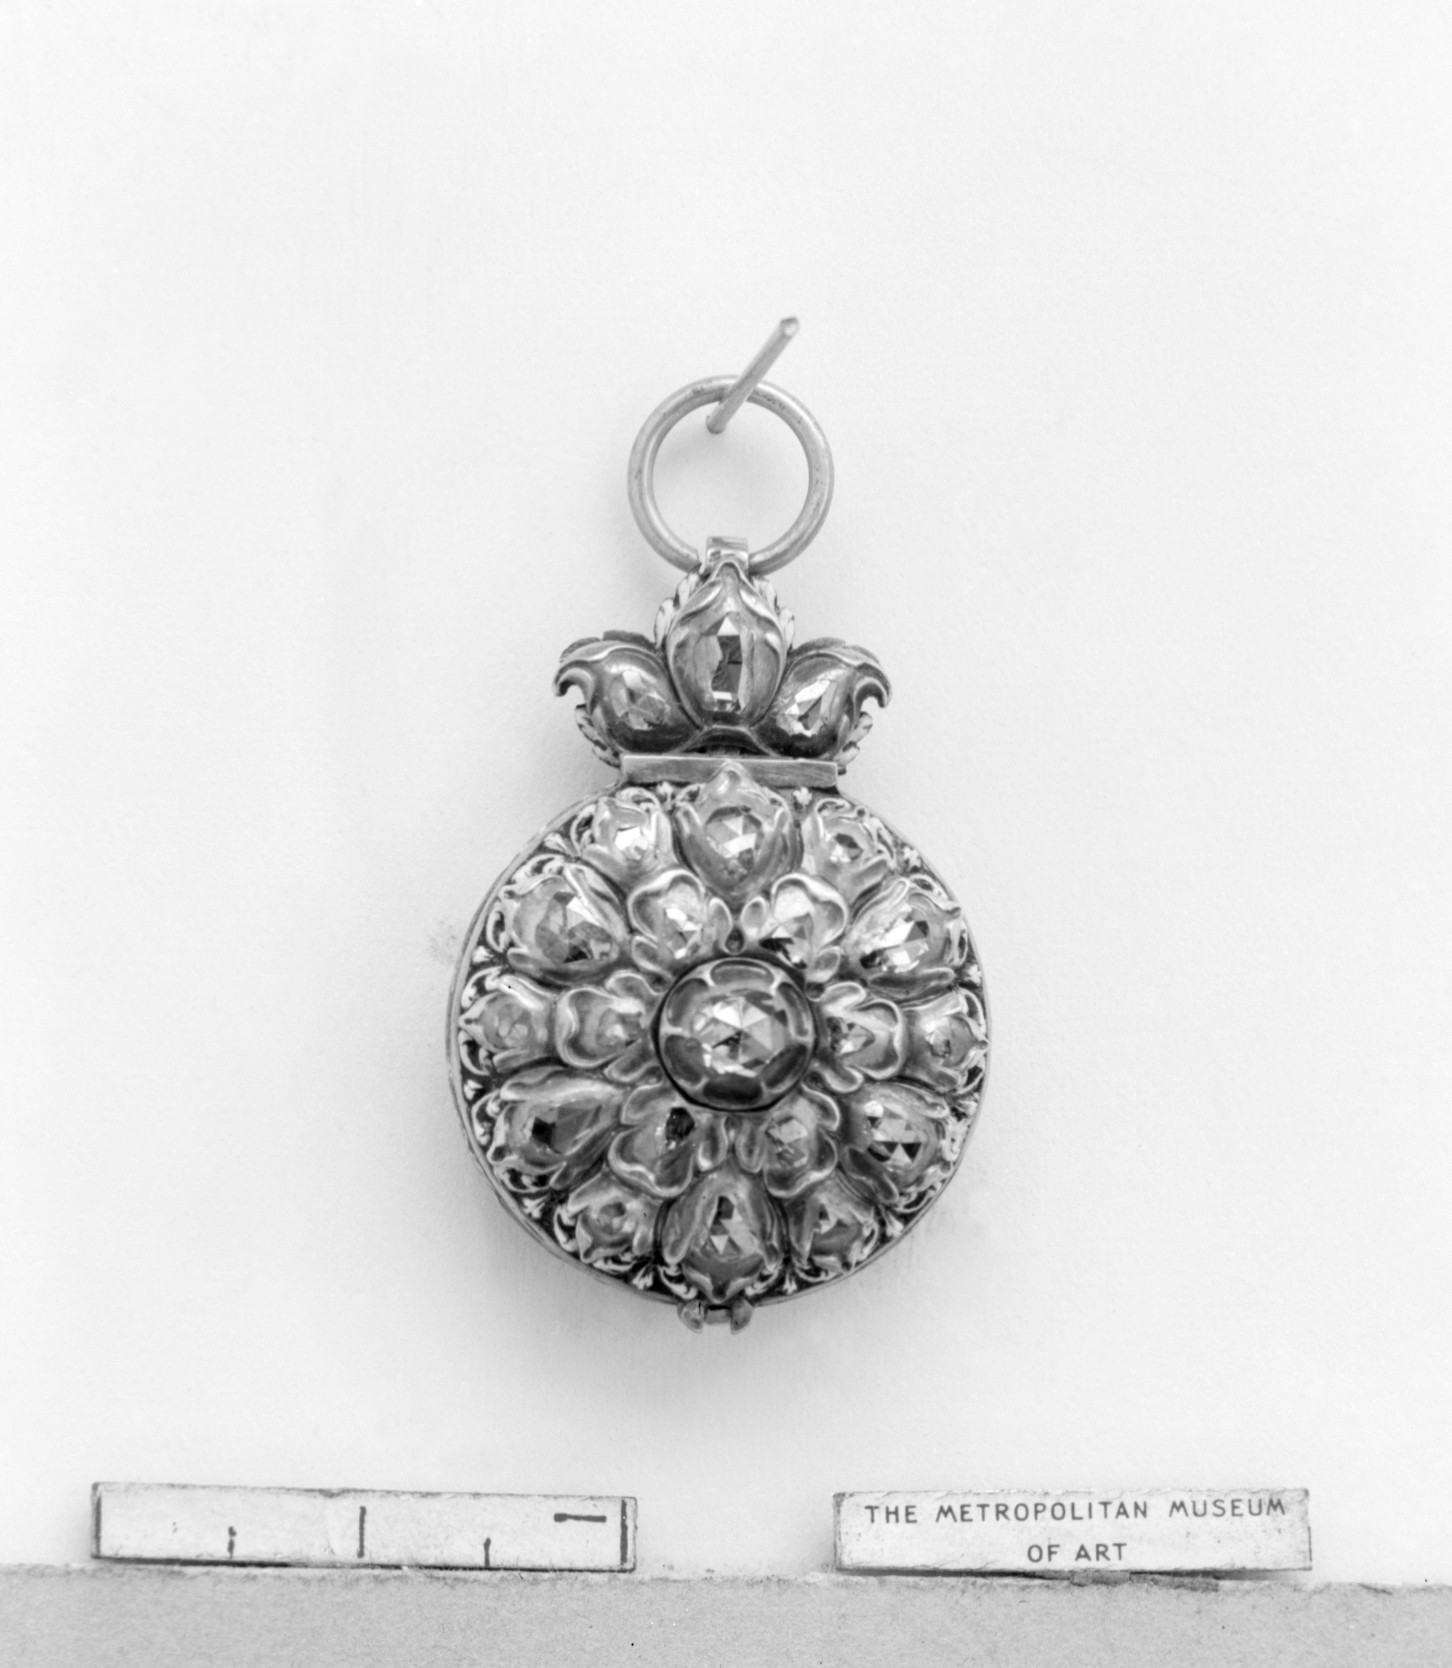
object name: watch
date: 1690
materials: diamond, enamel, metal